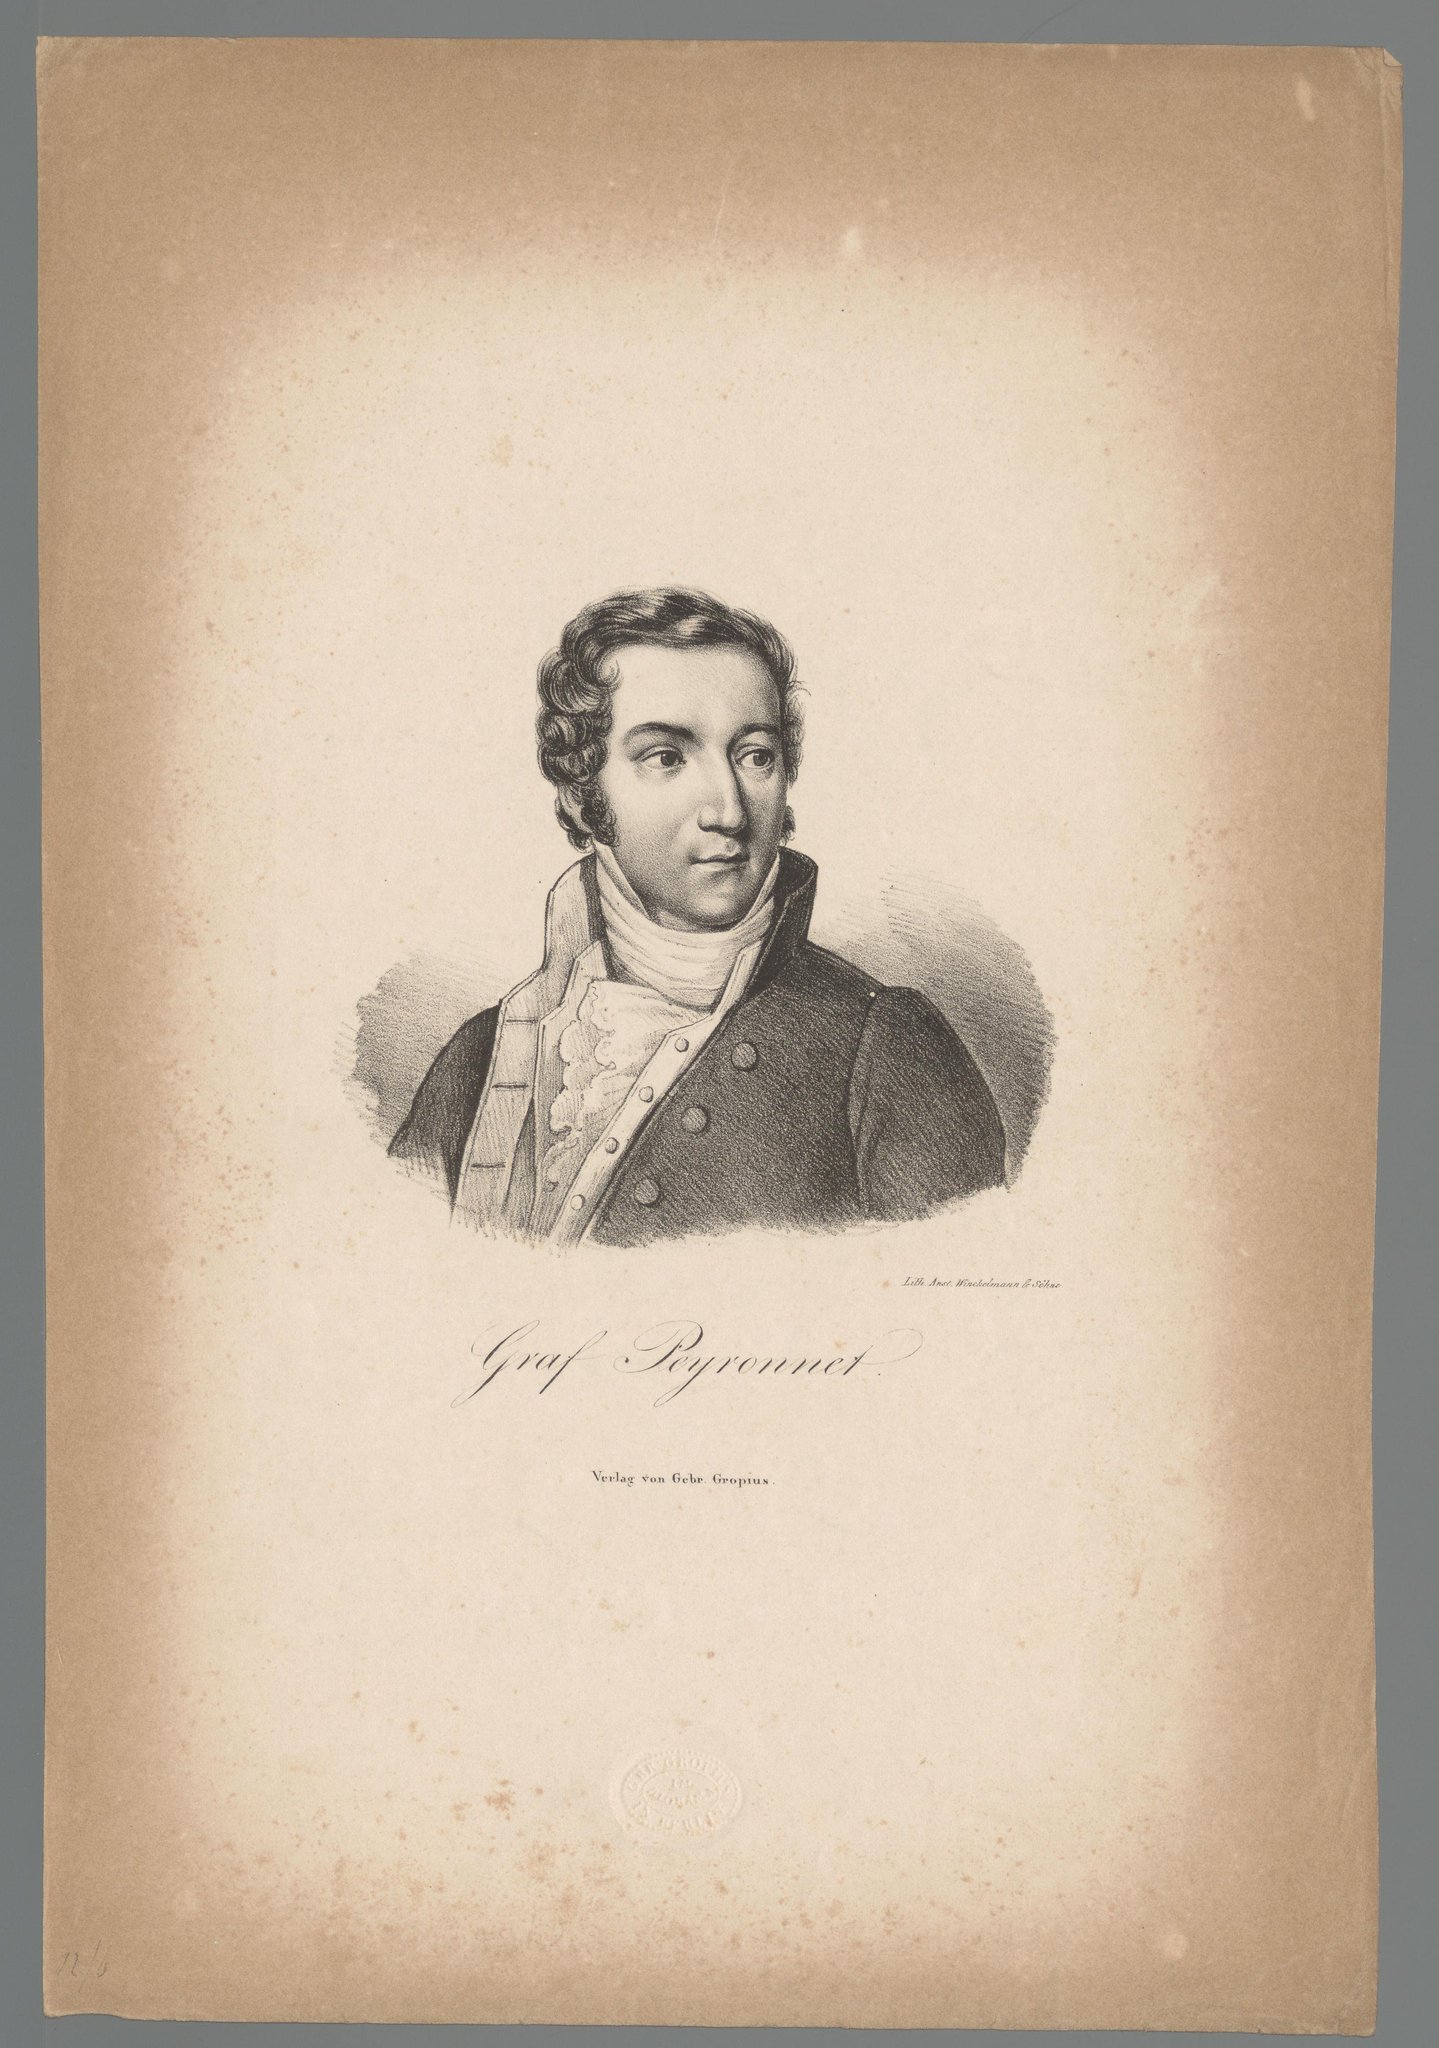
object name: print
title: Graf Peyronnet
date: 1830-1870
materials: paper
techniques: lithograph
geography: berlin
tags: politician, adult man, historical persons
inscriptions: check stamp: Lugt 5415, collector's mark: Lugt 2228